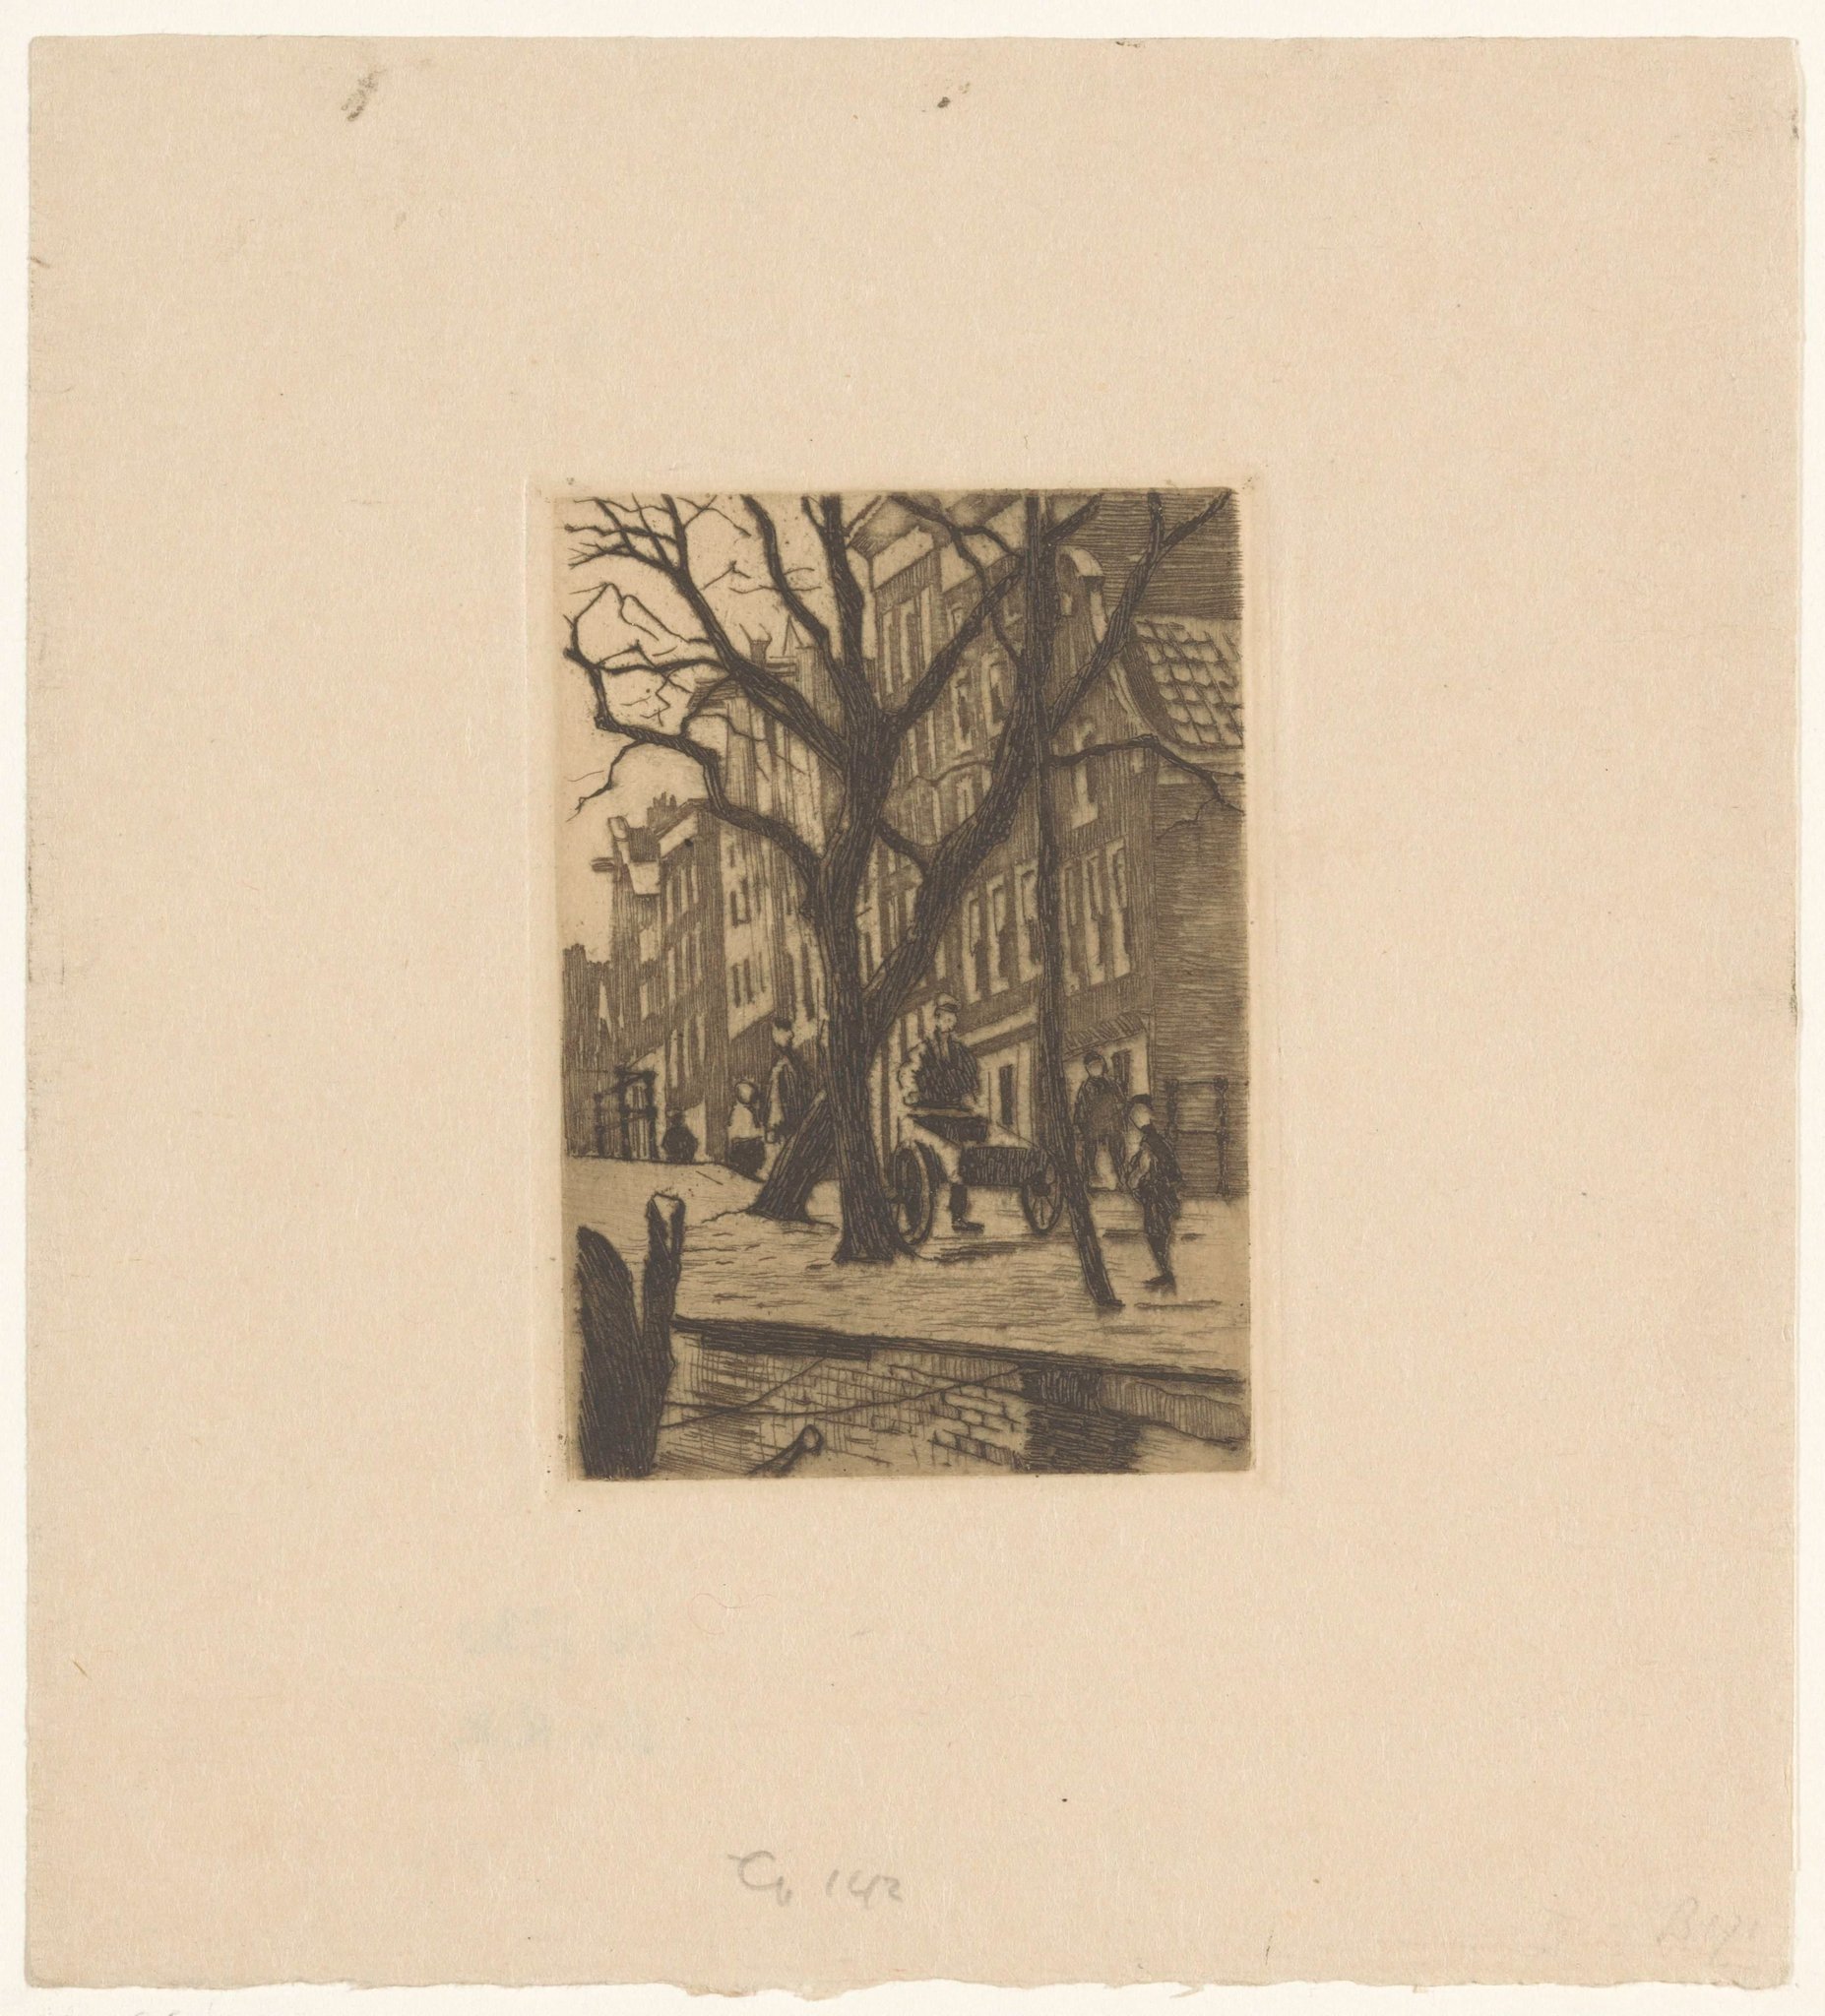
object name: print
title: Gezicht op huizen aan de Oude Schans in Amsterdam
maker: willem witsen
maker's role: draughtsman, painter, print maker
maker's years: 1860-1923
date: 1913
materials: paper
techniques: etching, intaglio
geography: amsterdam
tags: urban housing, trees, urban life